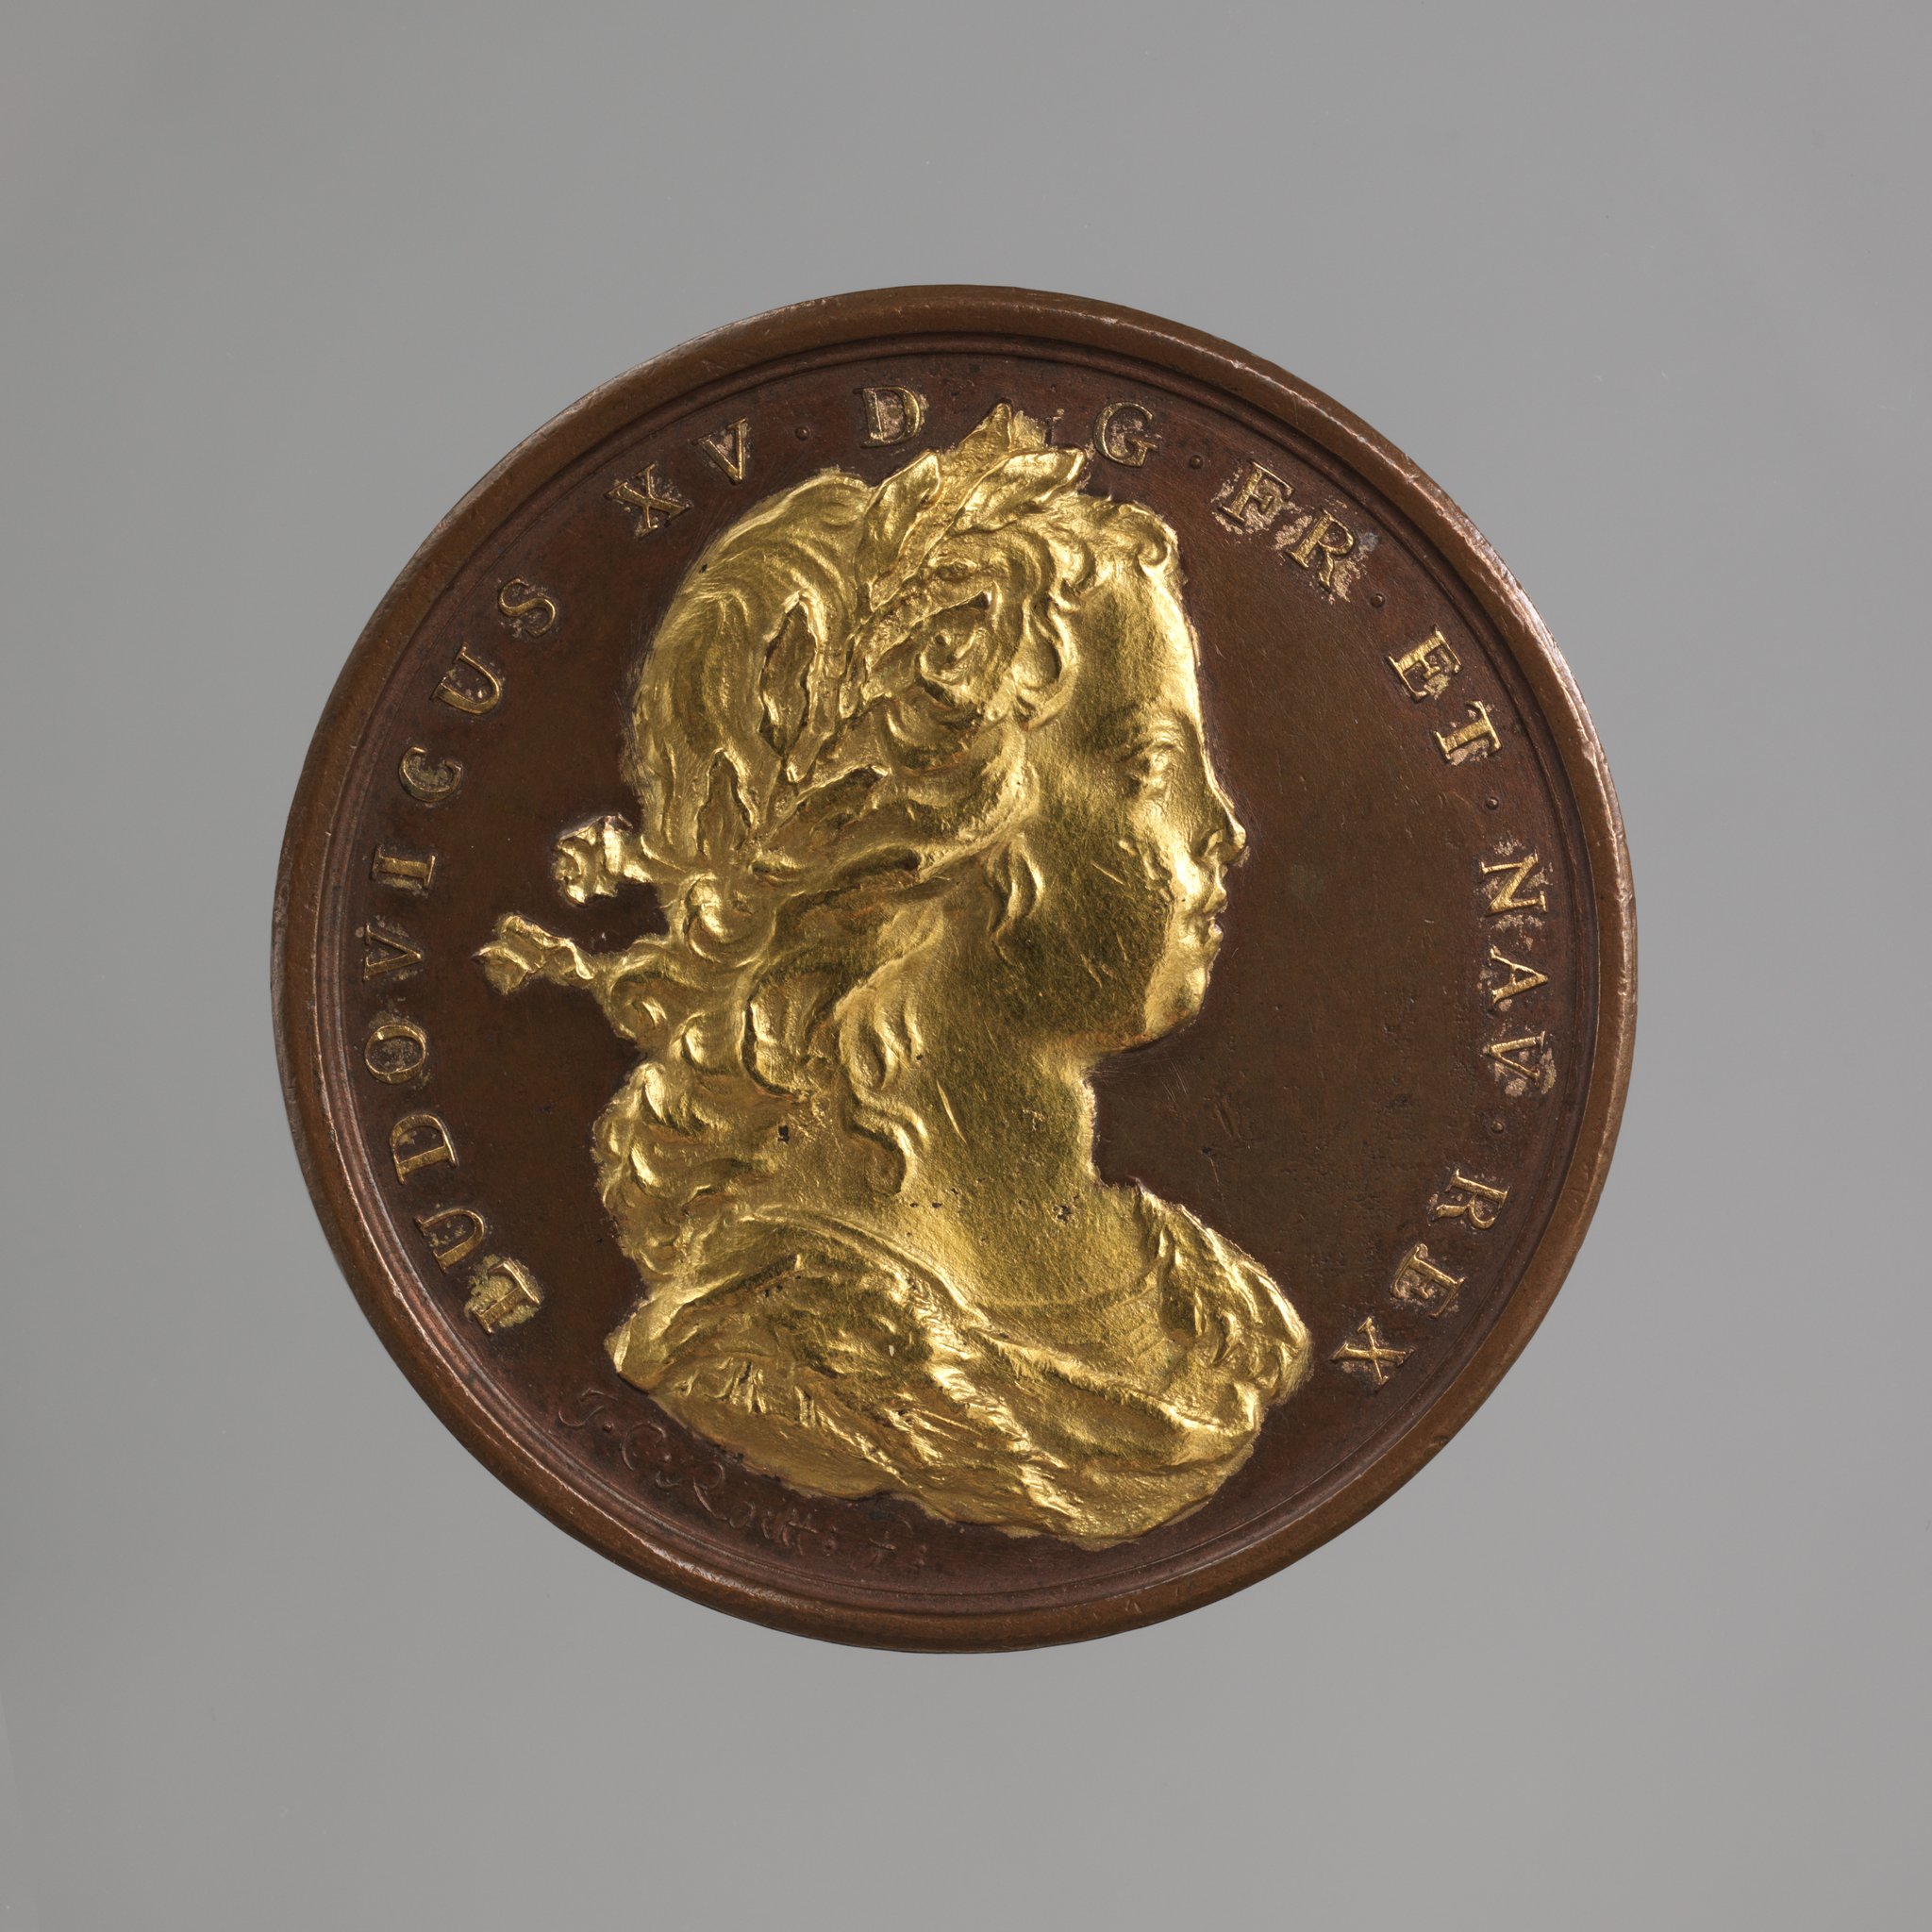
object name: medal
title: Louis XV: Progress of the King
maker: joseph-charles roettiers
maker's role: artist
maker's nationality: french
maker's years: 1691-1779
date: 1718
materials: gilt bronze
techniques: lacquer